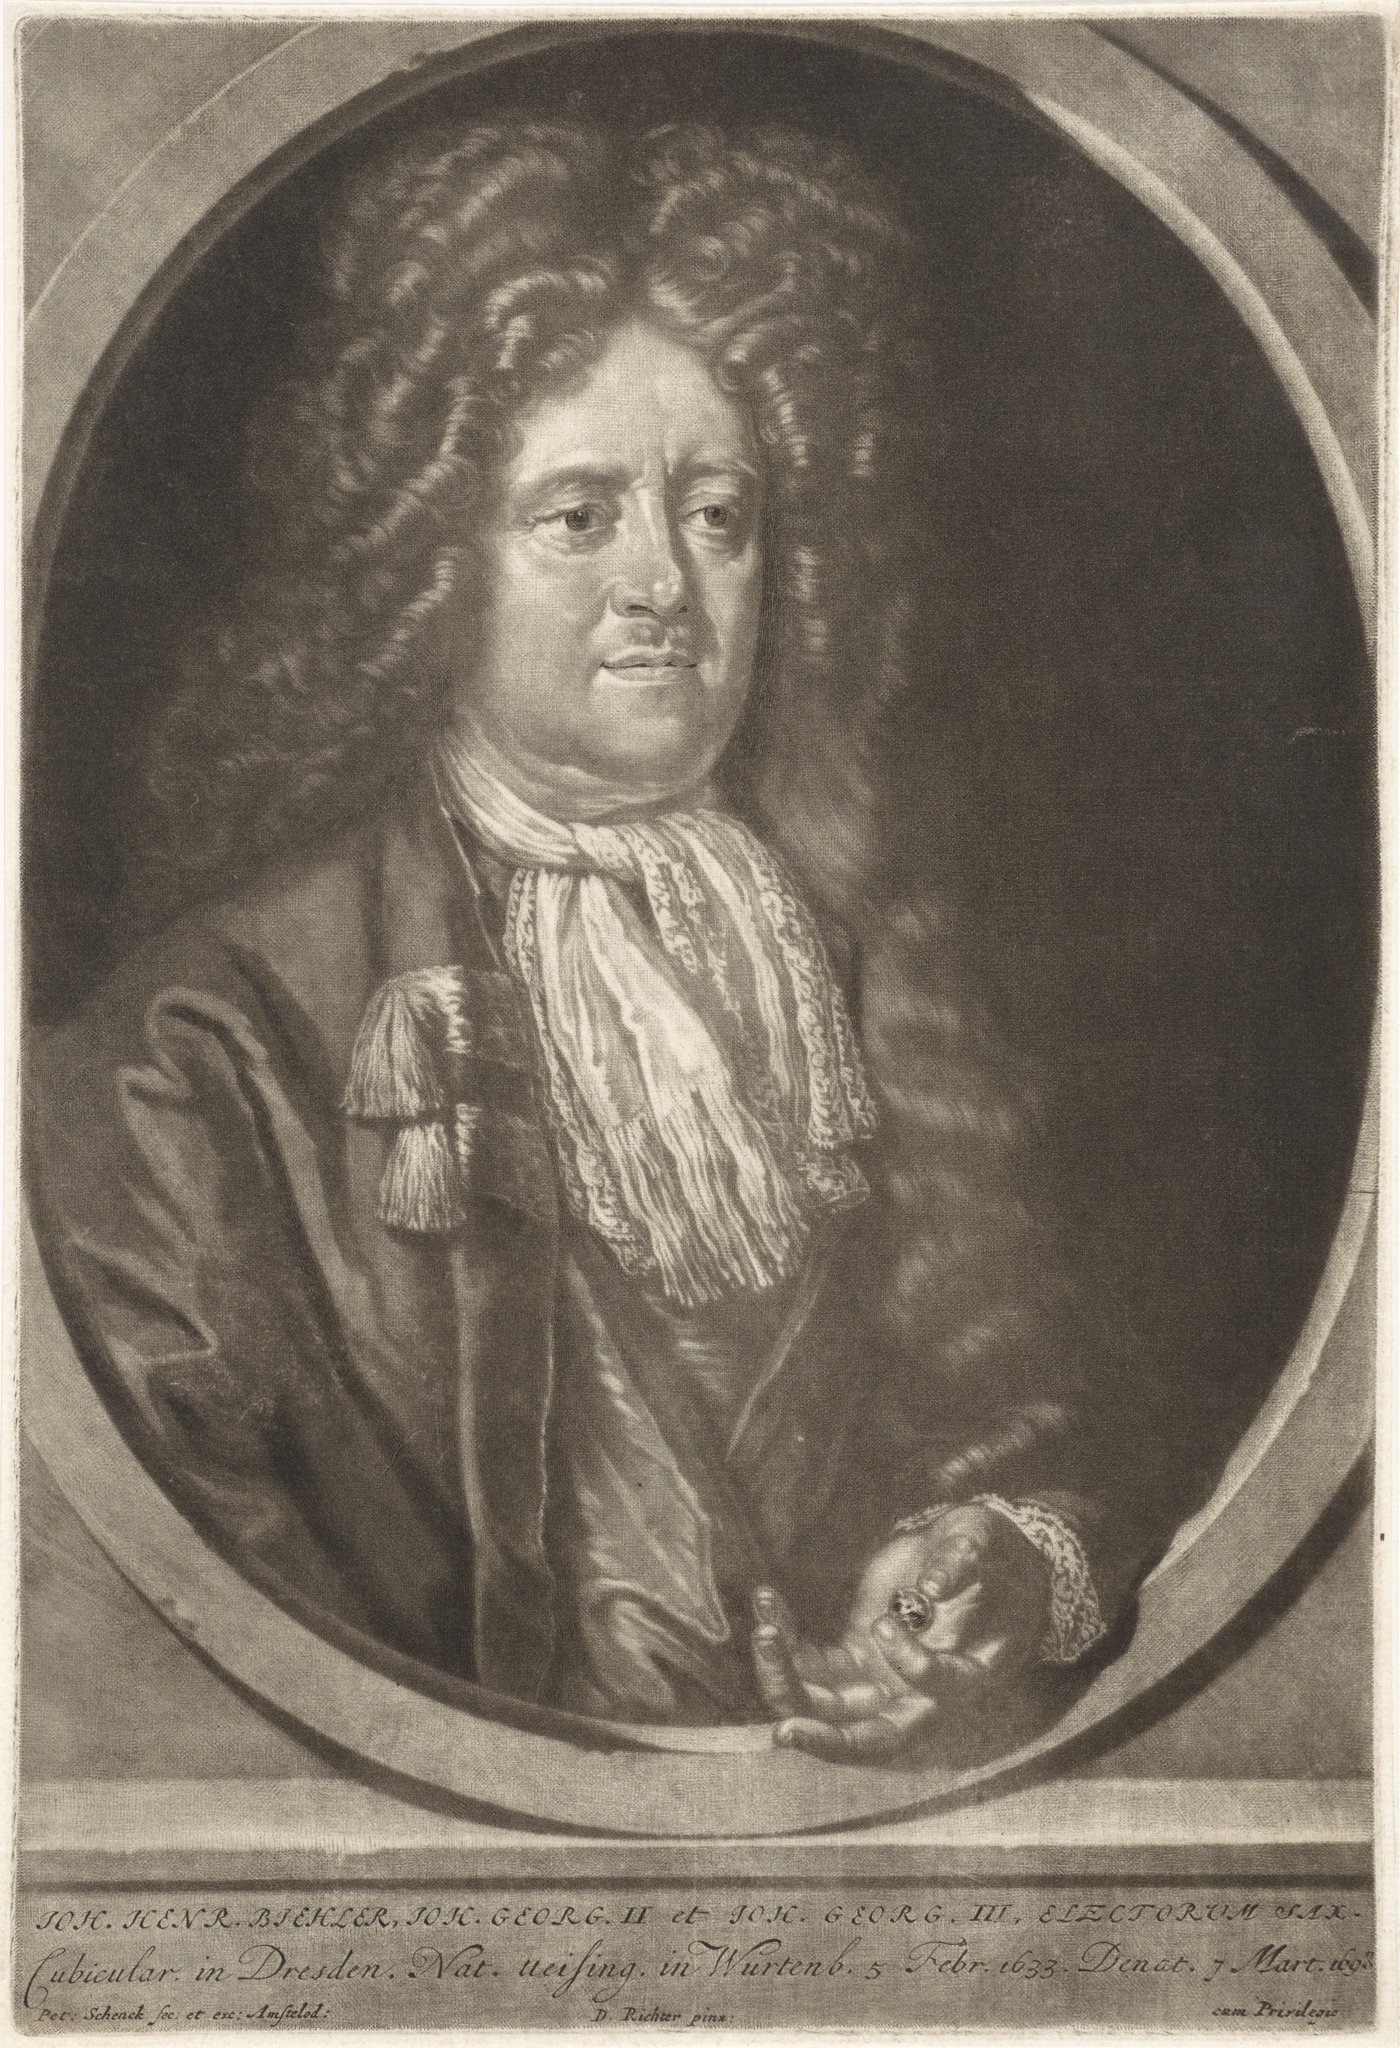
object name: print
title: Portret van Johann Heinrich Biehler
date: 1698-1713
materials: paper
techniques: engraving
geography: amsterdam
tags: wig, gem, gemstone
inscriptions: collector's mark: Lugt 2228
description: De hofjuwelier Johann Heinrich Biehler met in zijn hand een edelsteen. Hij draagt en pruik.